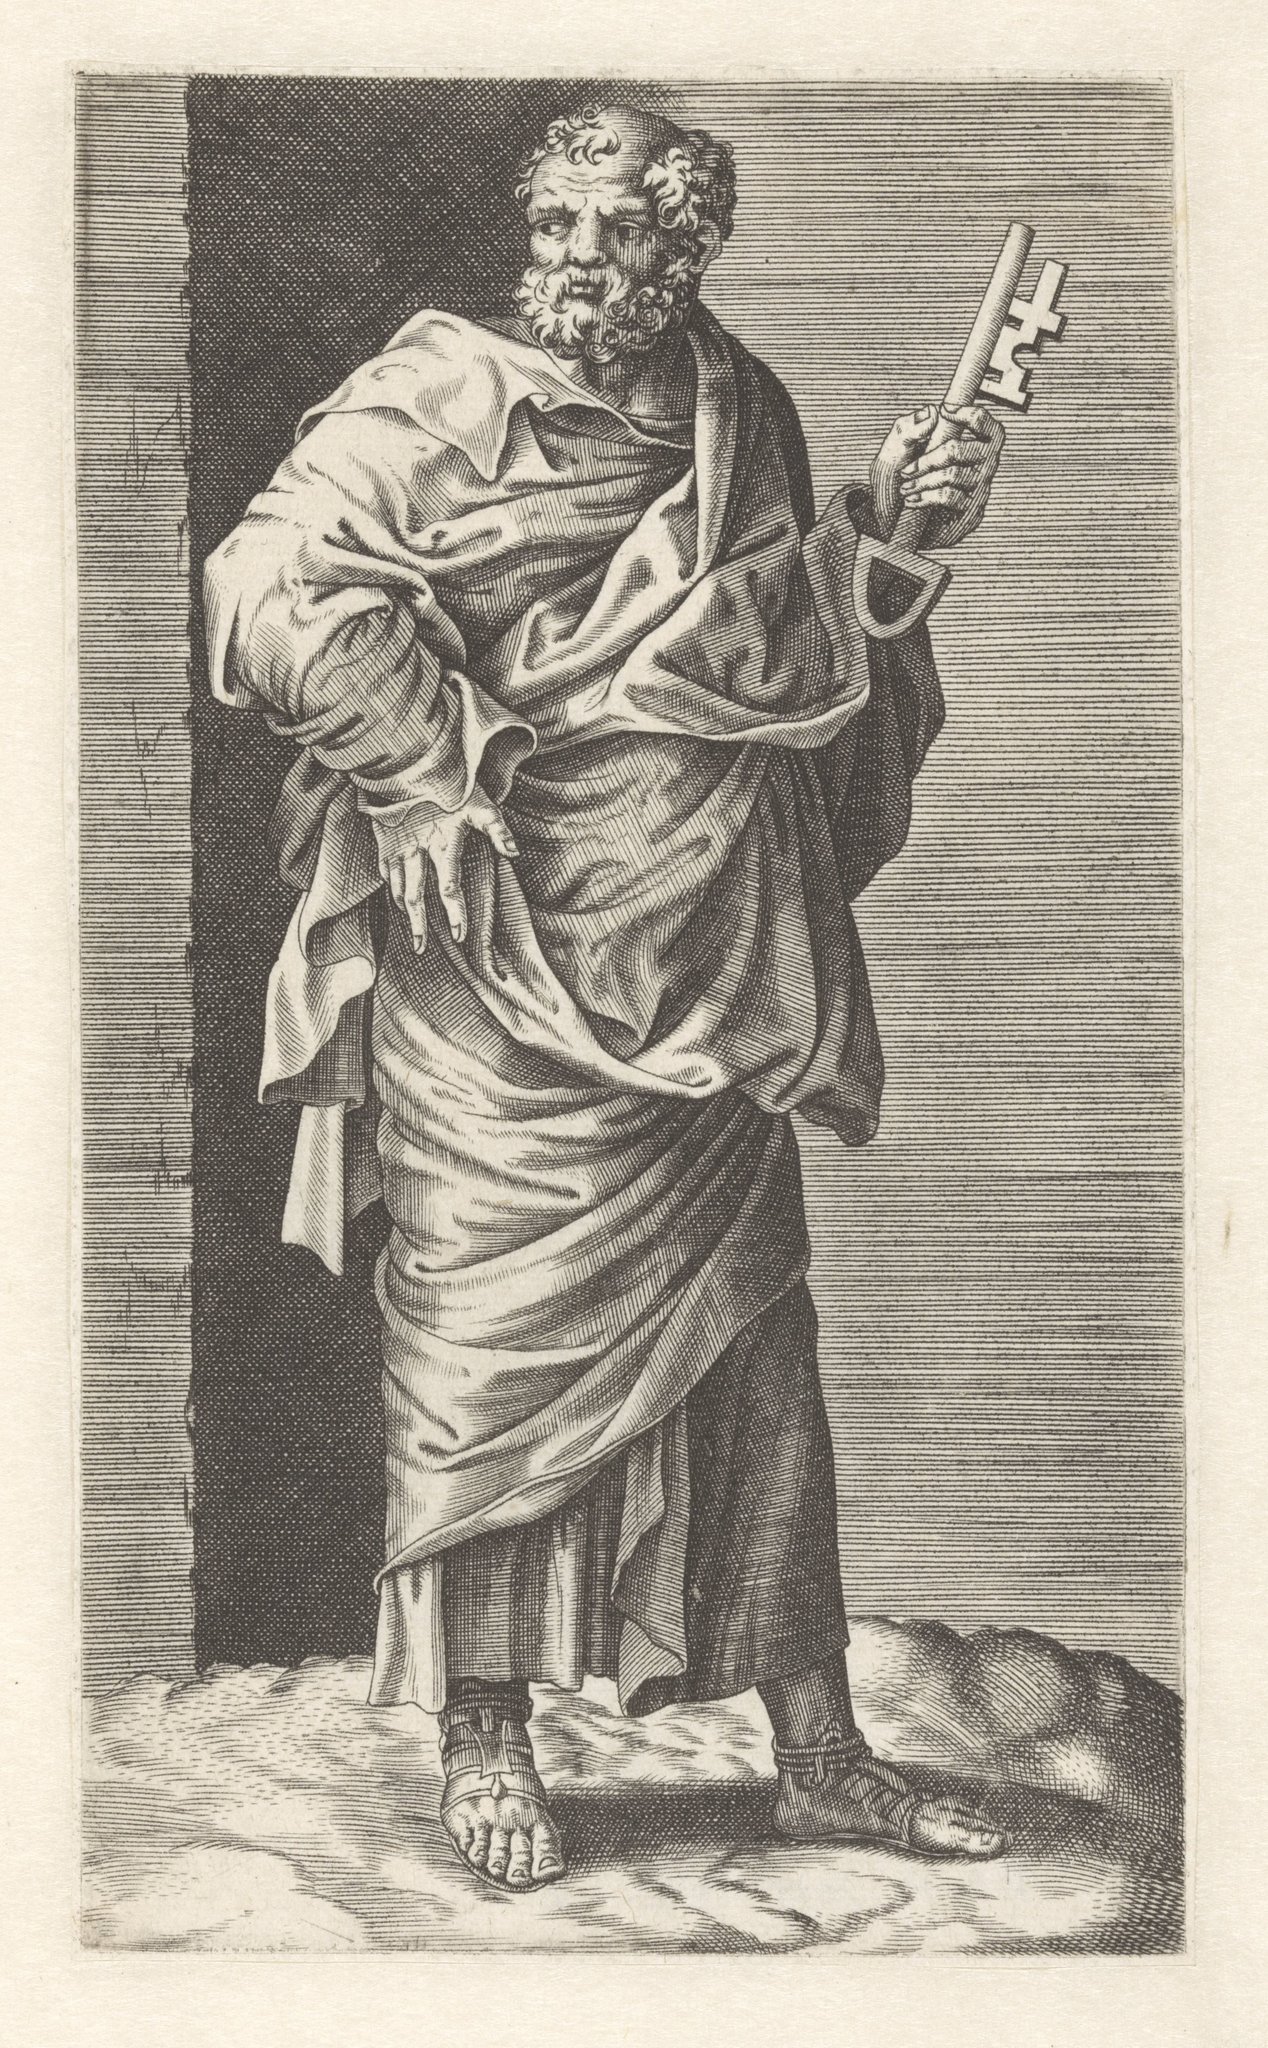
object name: print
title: Christus en twaalf apostelen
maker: Anonymous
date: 1555-1565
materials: paper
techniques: engraving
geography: netherlands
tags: adult christ together with apostles, evangelists, saints, etc., the twelve apostles (as a group), usually with books or scrolls (not in biblical context), the apostle peter, first bishop of rome; possible attributes: book, cock, (upturned) cross, (triple) crozier, fish, key, scroll, ship, tiara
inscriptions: collector's mark: Lugt 2228, collector's mark: Lugt 2760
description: Slechts één andere, complete serie bekend: in de Koninklijke Bibliotheek te Brussel. Proefdrukken, vóór de opschriften van de namen van Christus en de apostelen.